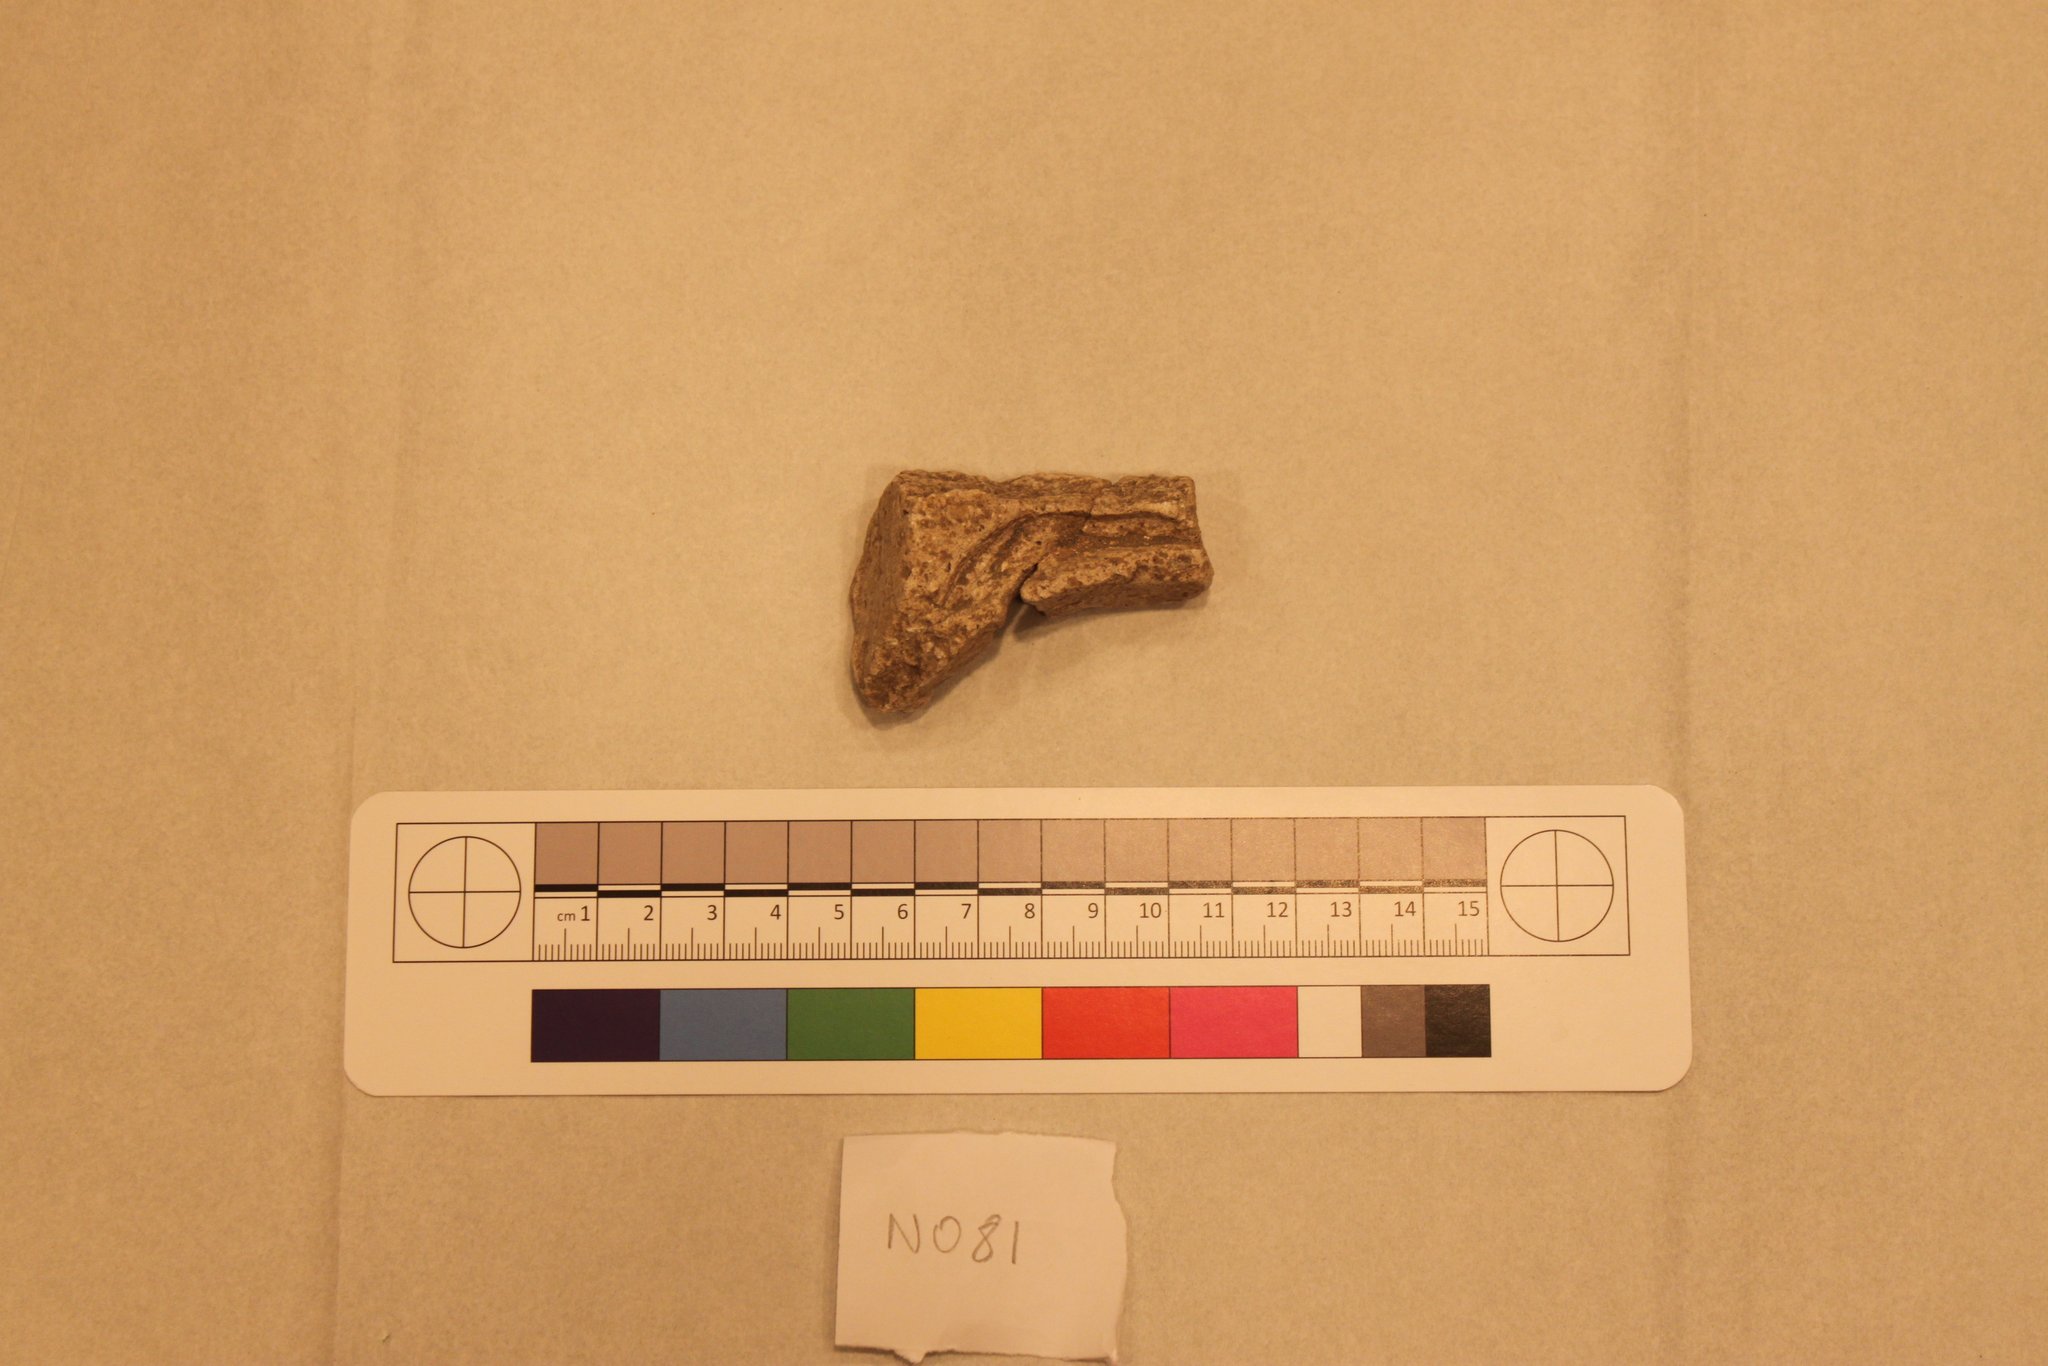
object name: fragment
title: Stucco Fragment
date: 701-1200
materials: plaster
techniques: carving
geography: iran